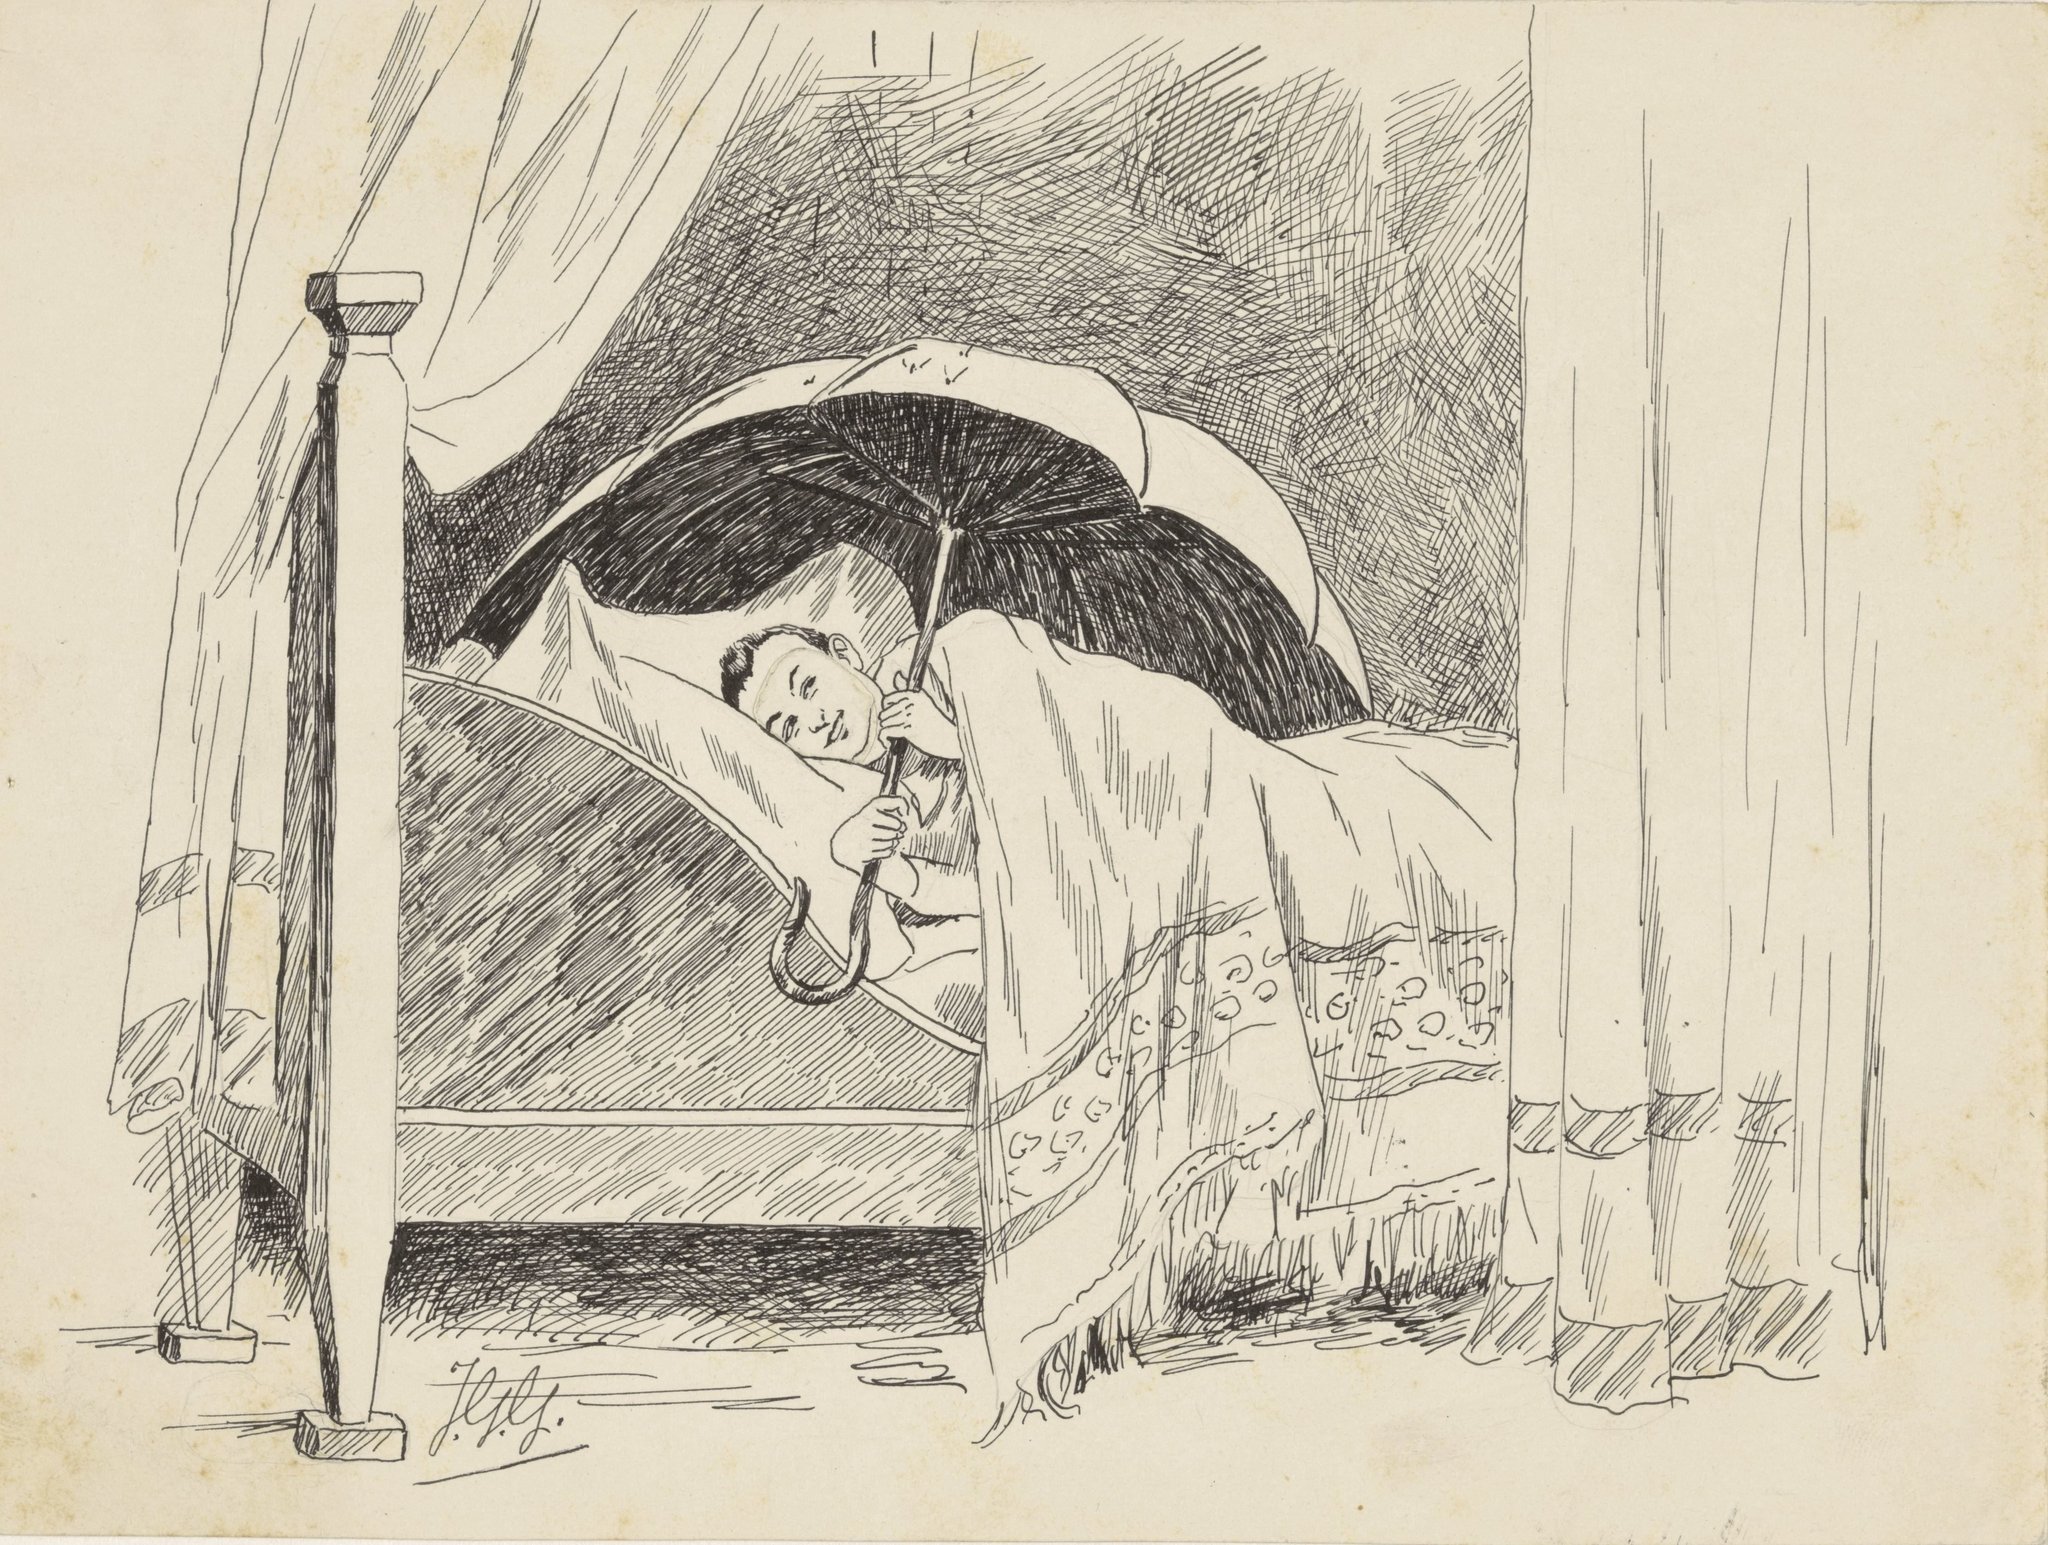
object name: boekillustratie ontwerp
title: Jongen met paraplu in een bed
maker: johan georg gerstenhauer zimmerman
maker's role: draughtsman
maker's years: 1858-1931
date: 1868-1931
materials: ink, paper, pencil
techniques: pen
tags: boy (child between toddler and youth), bed, umbrella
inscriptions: collector's mark: Lugt 2228a, signature: ‘J.G.G.’, :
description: Een jongen ligt op bed onder de dekens. Hij houdt een uitgeklapte paraplu boven zijn hoofd. Rond het bed hangen gordijnen.